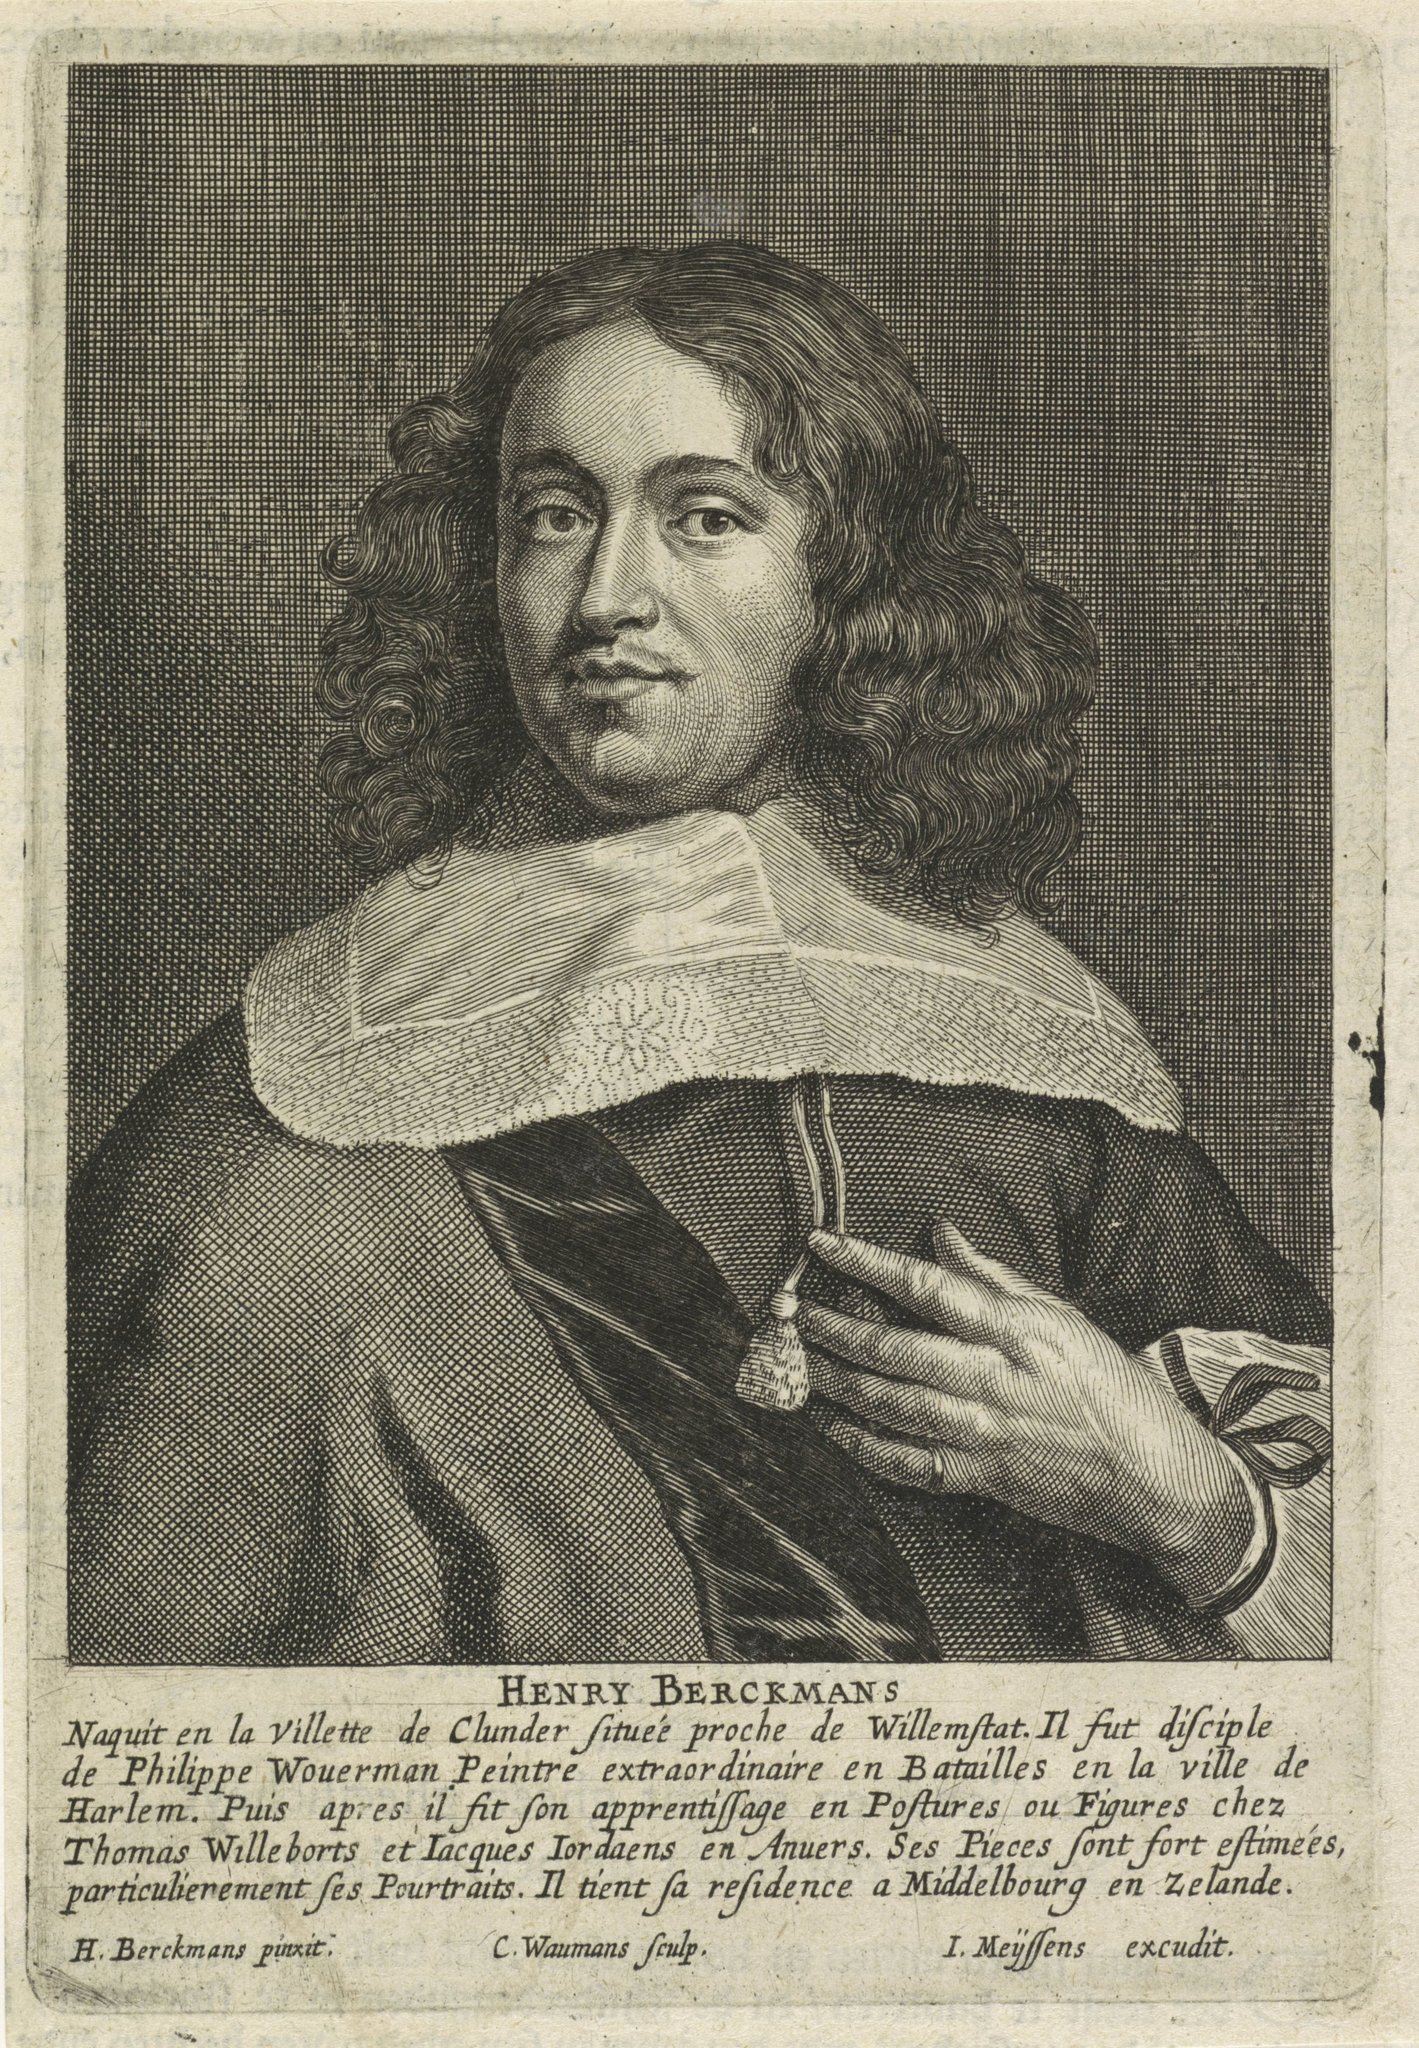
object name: print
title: Portret van de schilder Hendrick Berckman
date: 1662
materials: paper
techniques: engraving, letterpress printing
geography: antwerp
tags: painter, draughtsman, hendrick berckman, portrait, self-portrait of painter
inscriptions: collector's mark: Lugt 2228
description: Portret van de schilder Hendrick Berckman. In de marge de naam van de geportretteerde en een vijfregelig onderschrift met biografische gegevens in het Frans.